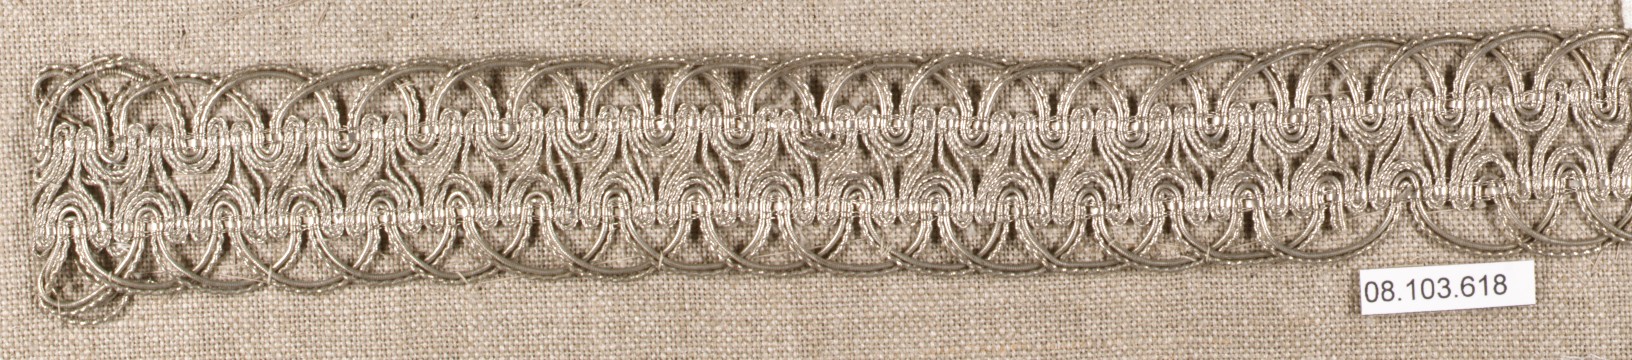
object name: galloon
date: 1601-1700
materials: metal thread